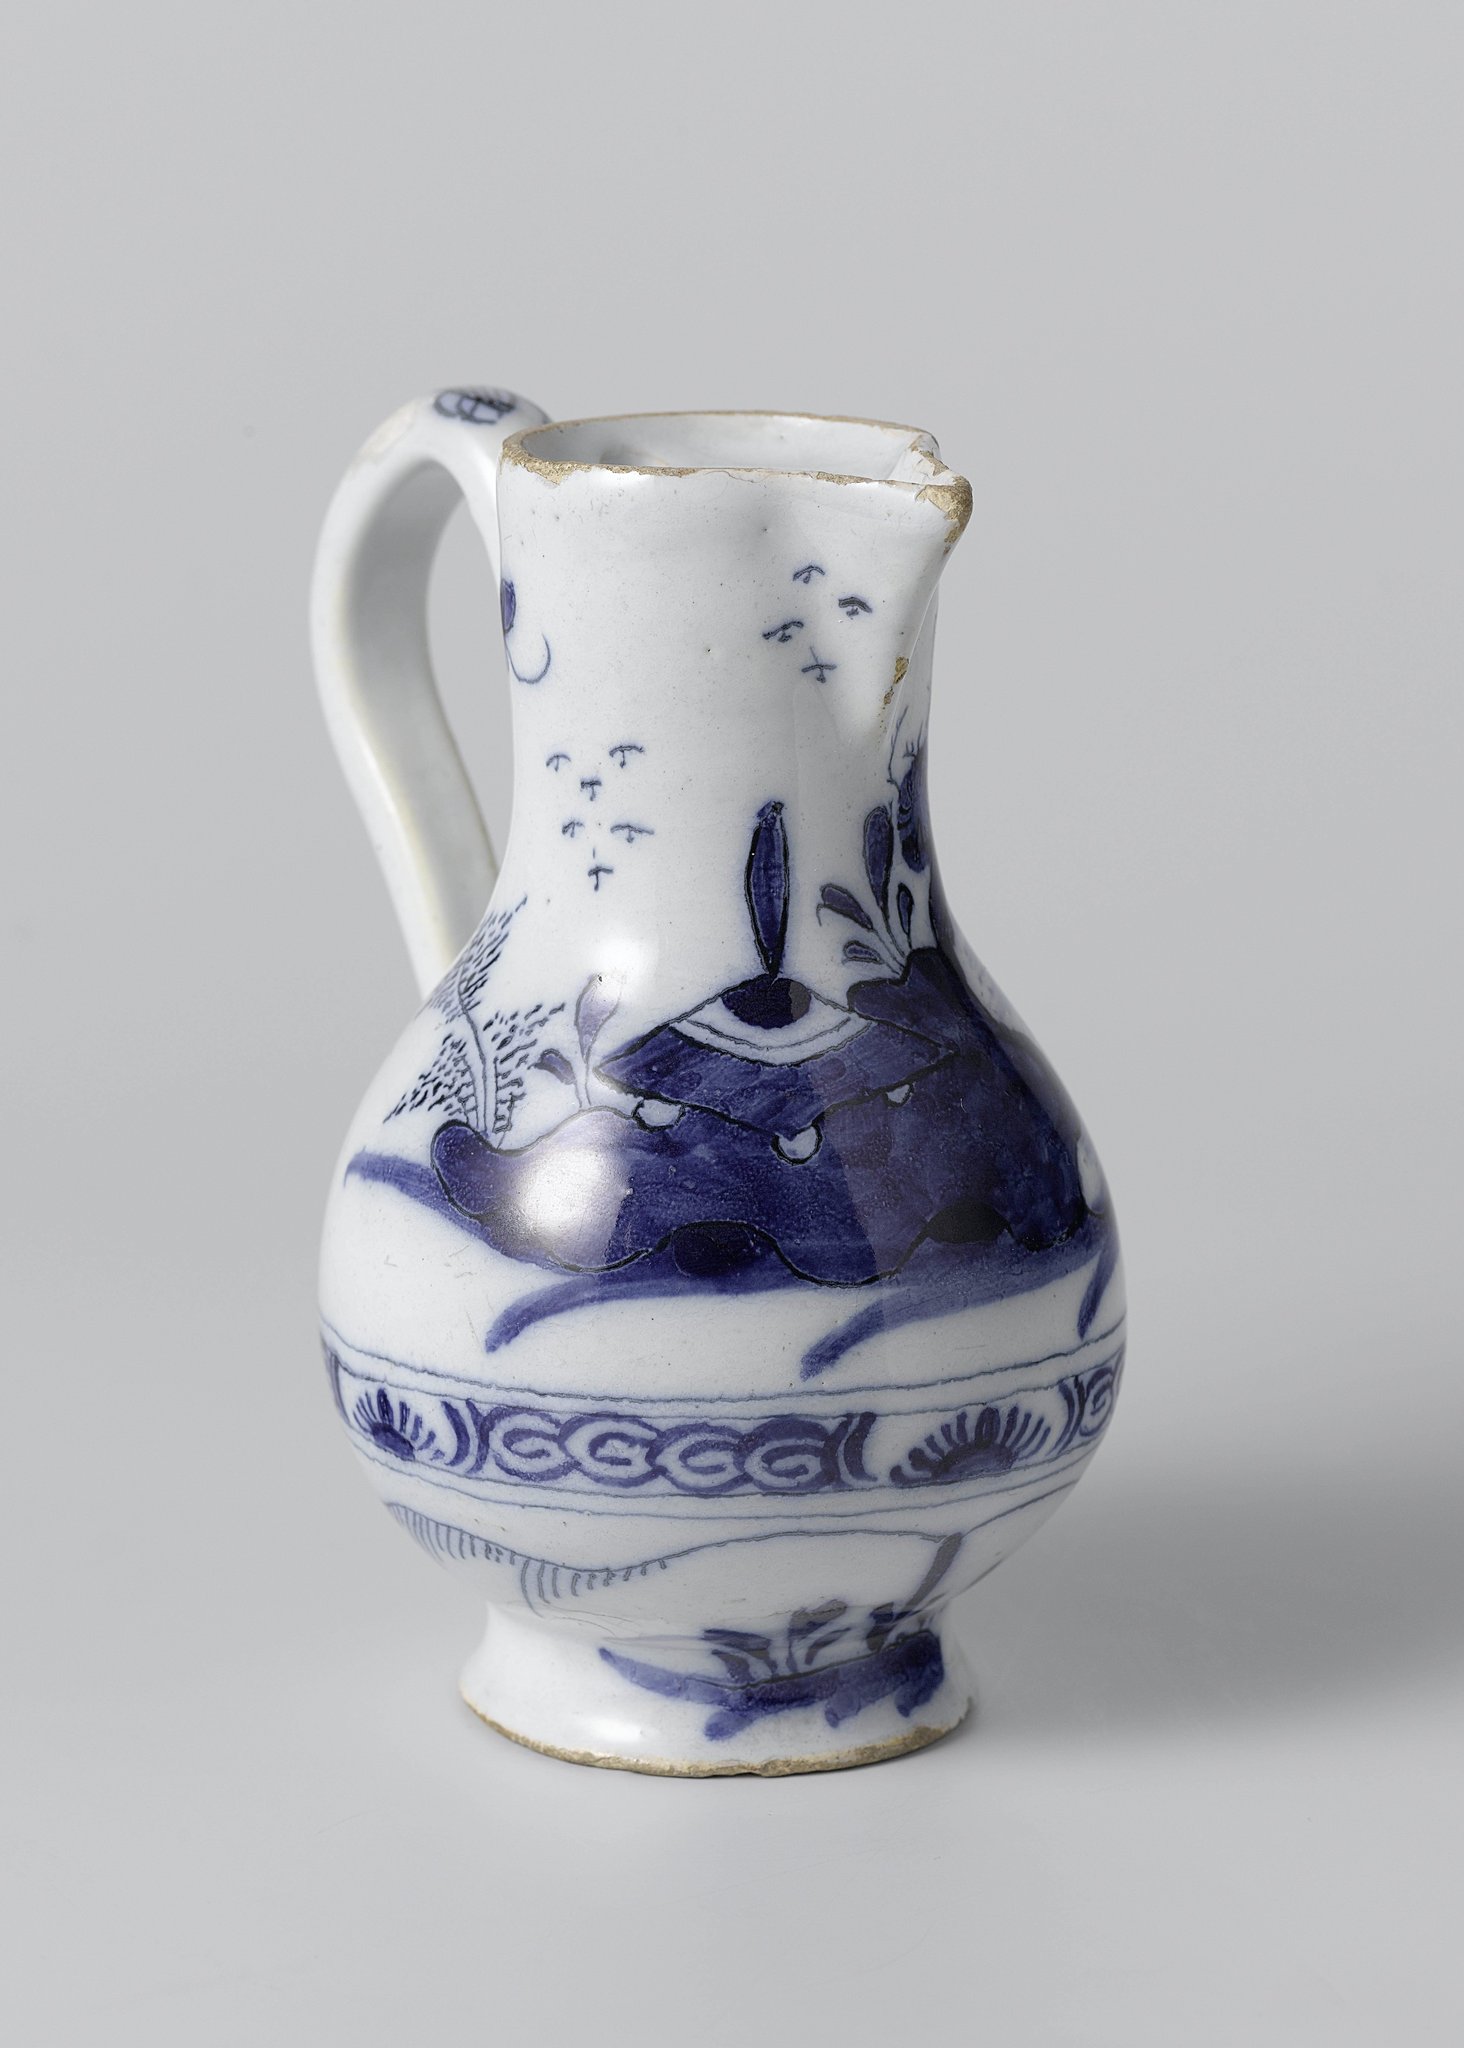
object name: ewer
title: Kan van faience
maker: Anonymous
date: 1740-1780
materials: earthenware, glaze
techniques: painted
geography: delft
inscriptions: inscription: ‘f 5,-’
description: Kan van blauw beschilderde faience, op een voet, met een oor, een schenktuit en een deksel. Op de schouder is een landschap geschilderd.